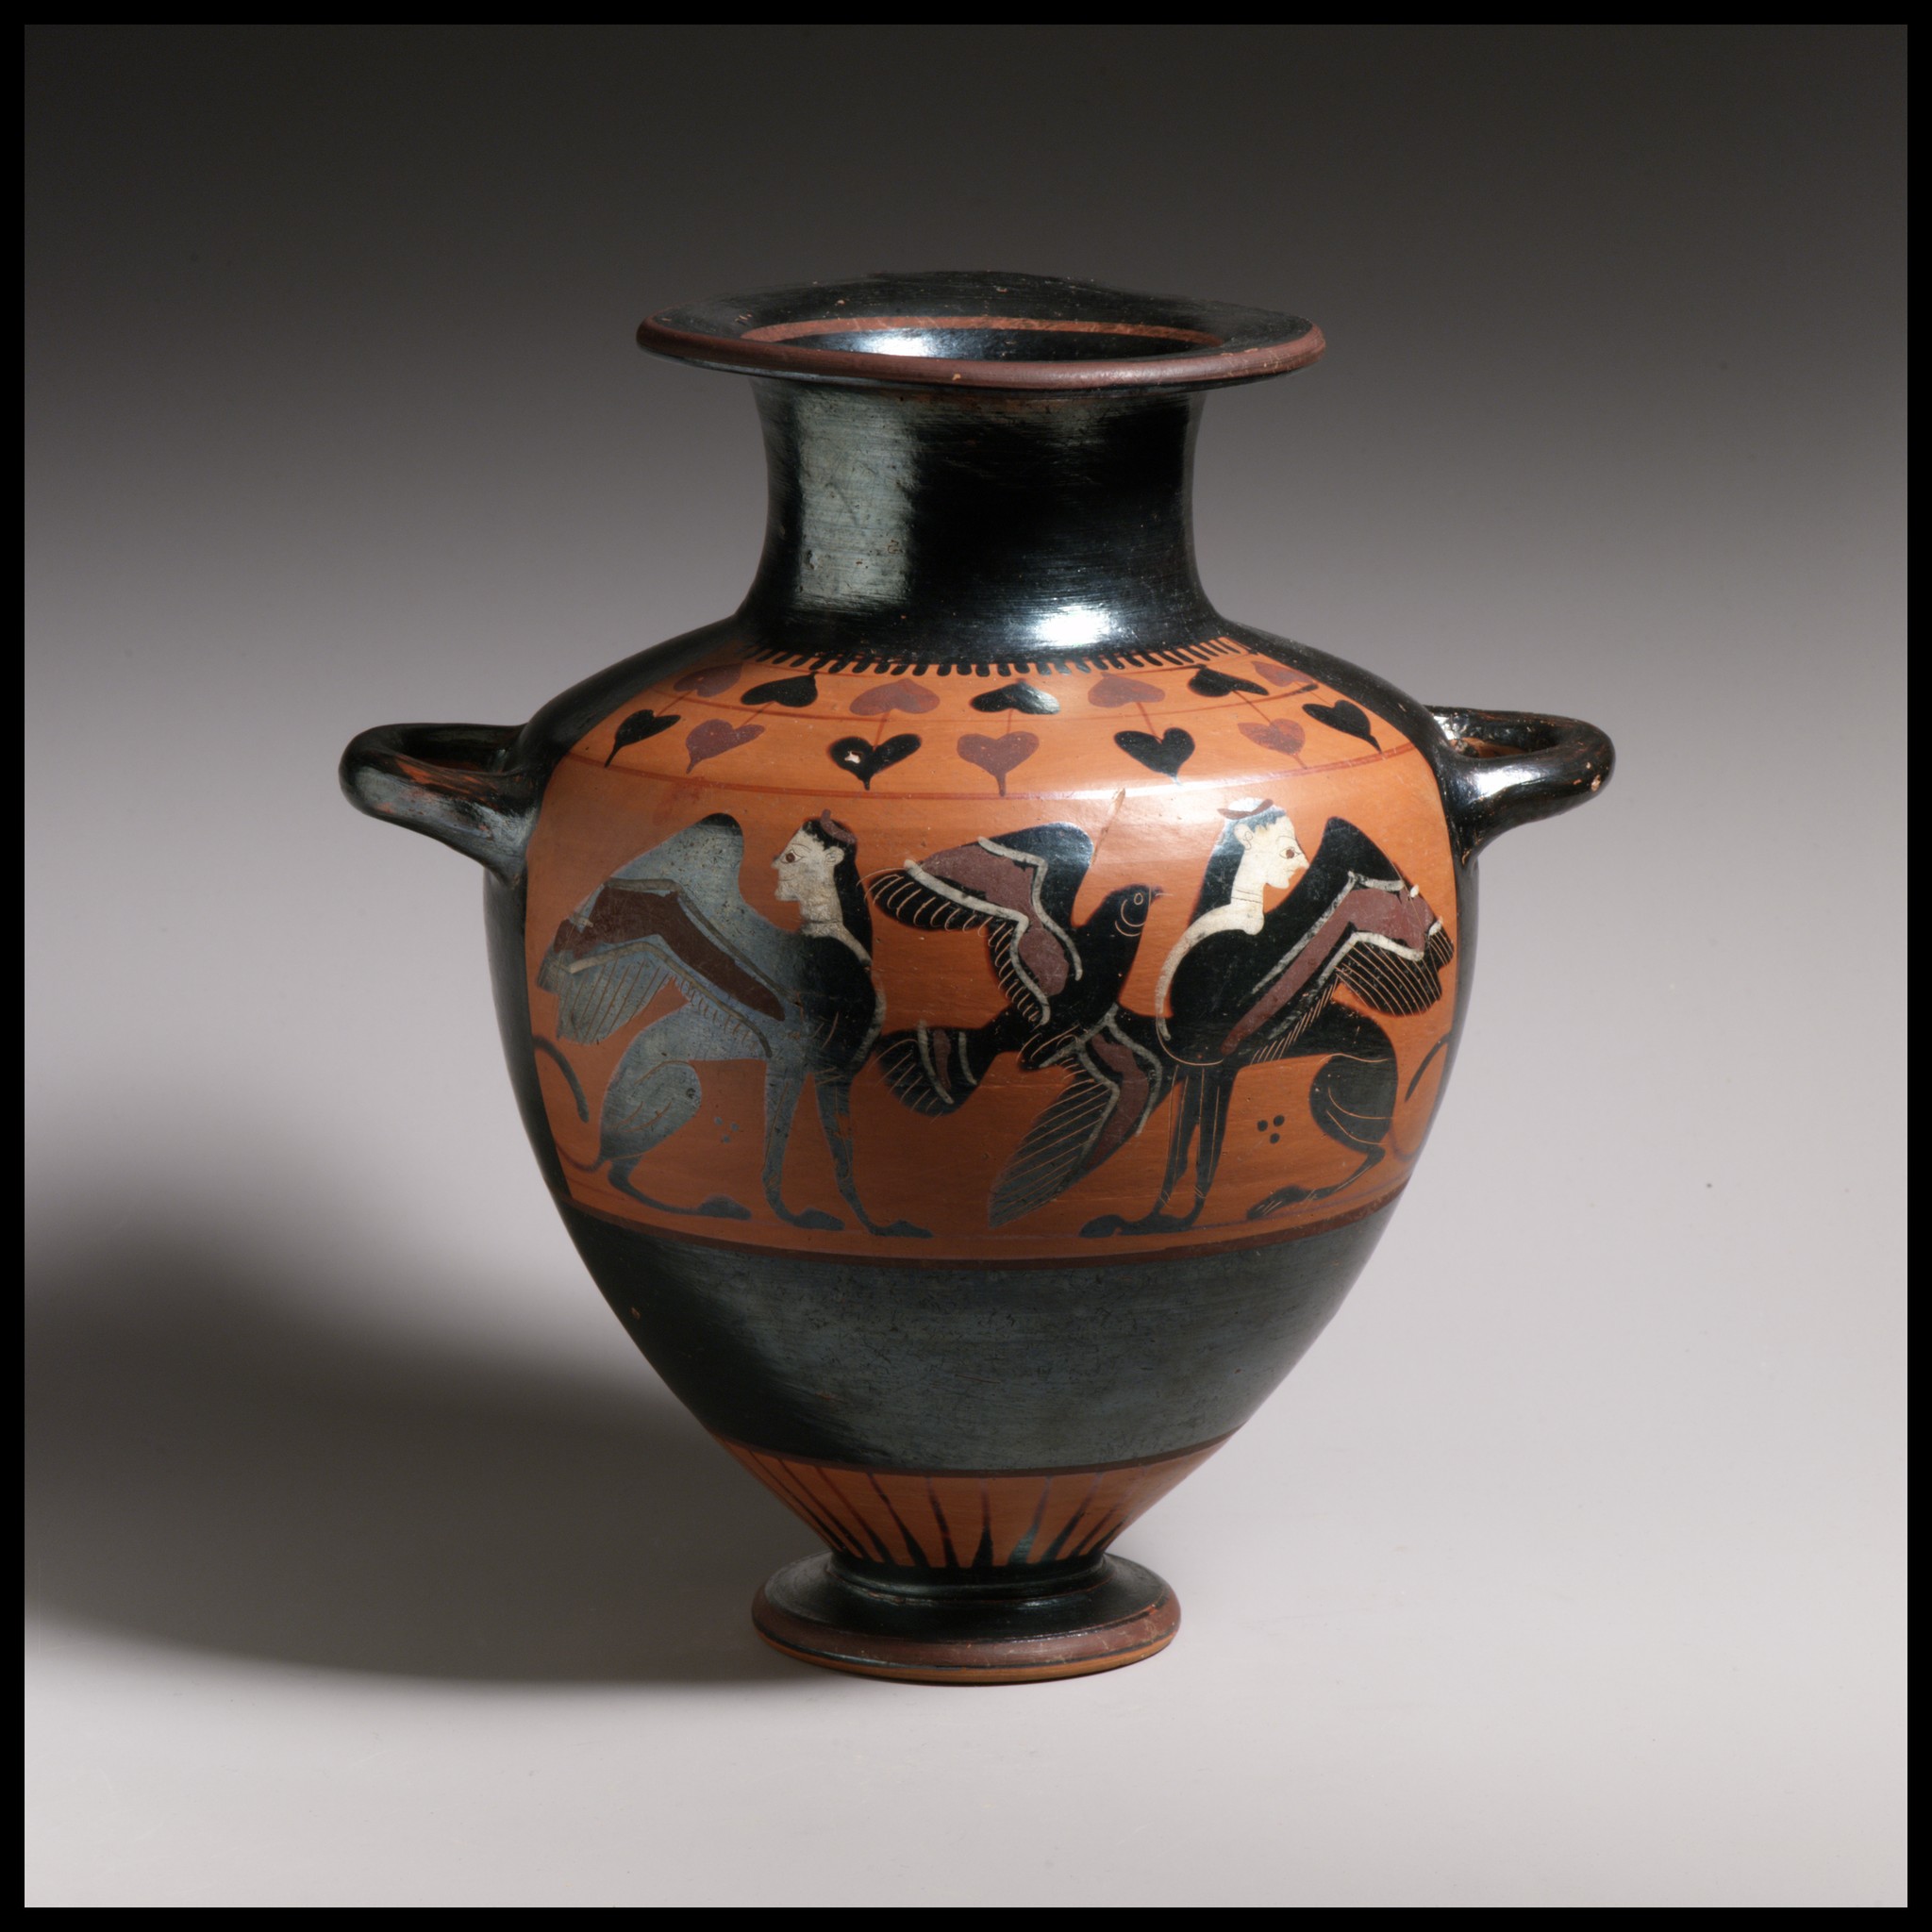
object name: hydria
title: Terracotta hydria (water jar)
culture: greek, euboean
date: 567-535 BCE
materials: terracotta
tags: eagles,sphinx